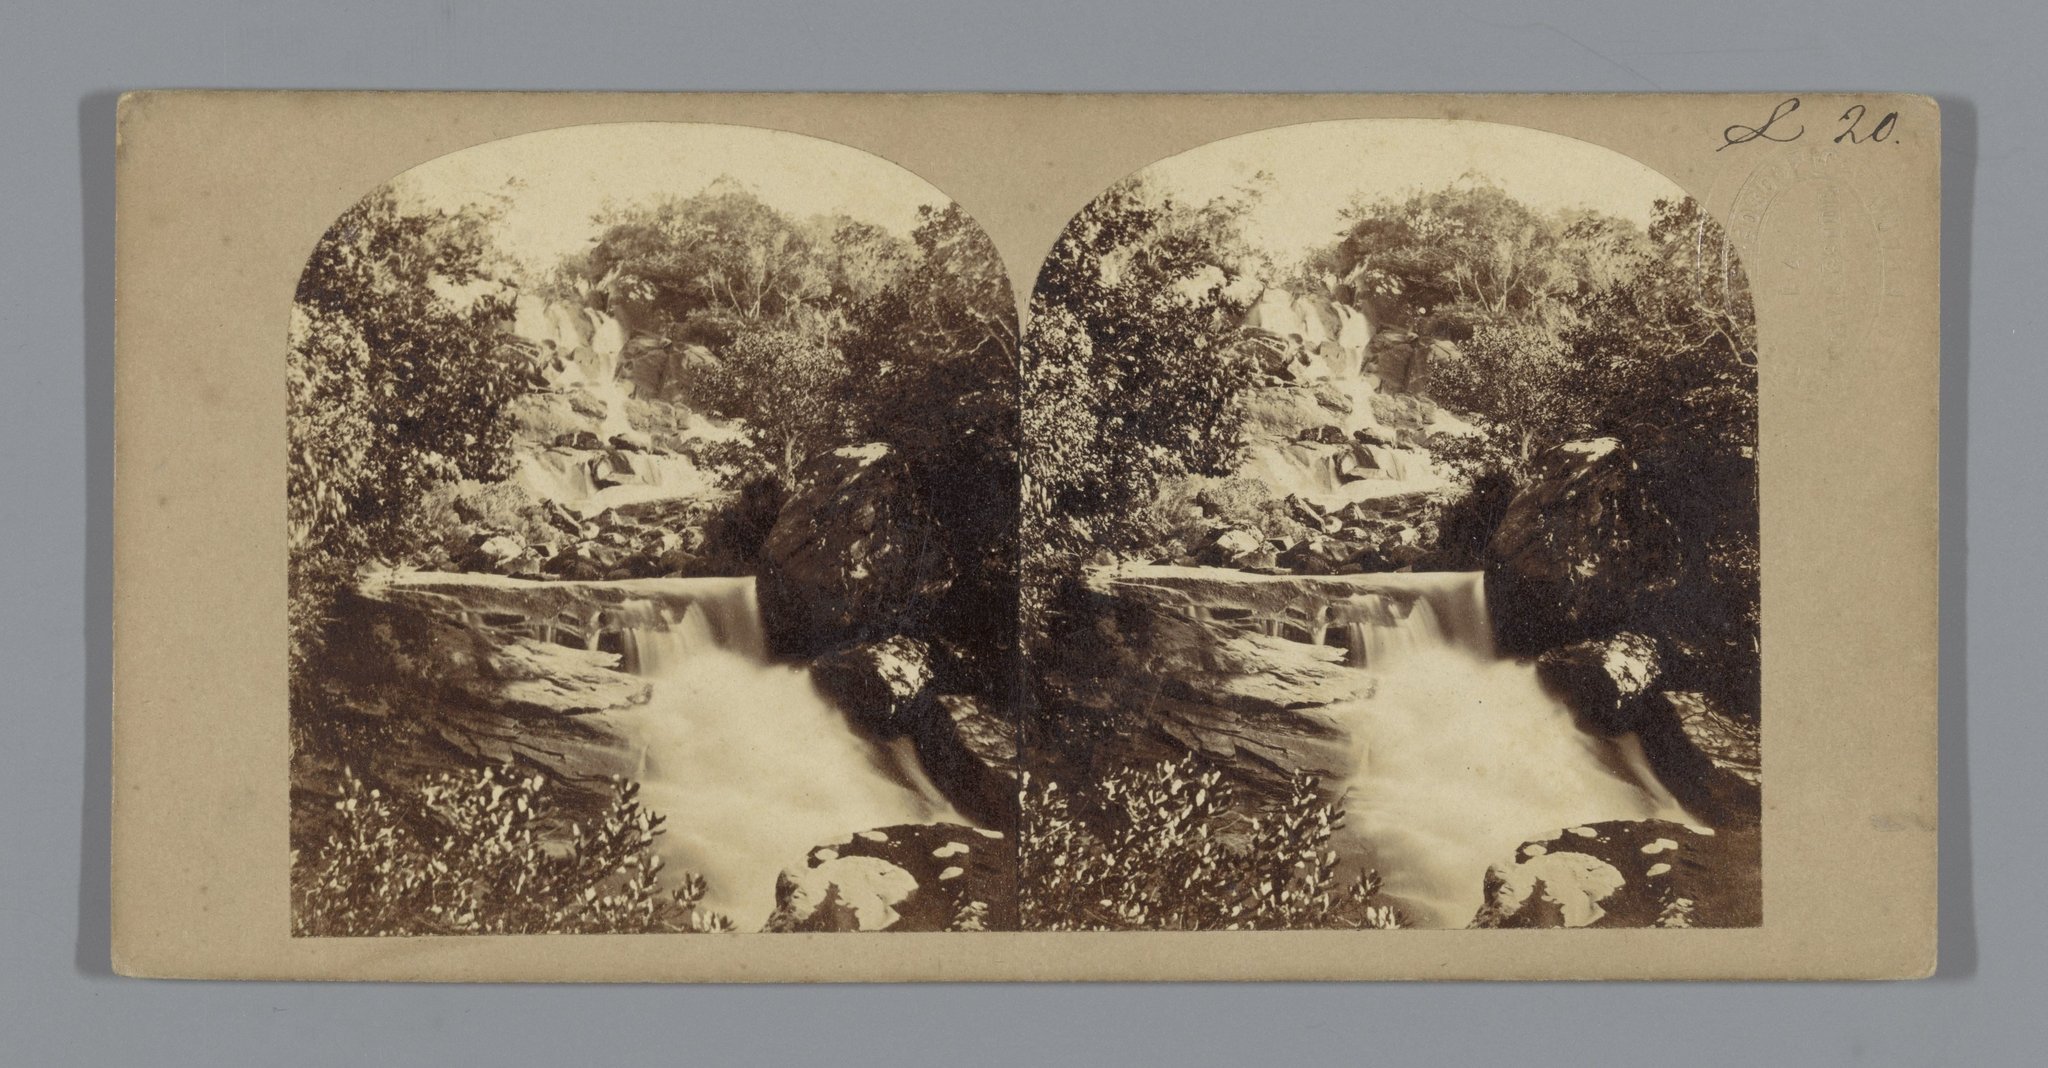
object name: stereograph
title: Gezicht op de Derrycunihy Waterfall bij Killarney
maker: william england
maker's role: fotograaf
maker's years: 1816-1896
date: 1858-1859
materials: cardboard, photographic support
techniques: albumen print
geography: london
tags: waterfall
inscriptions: name: ‘London Stereoscopic Company 54 Cheapside’, inscription, number: ‘L 20.’